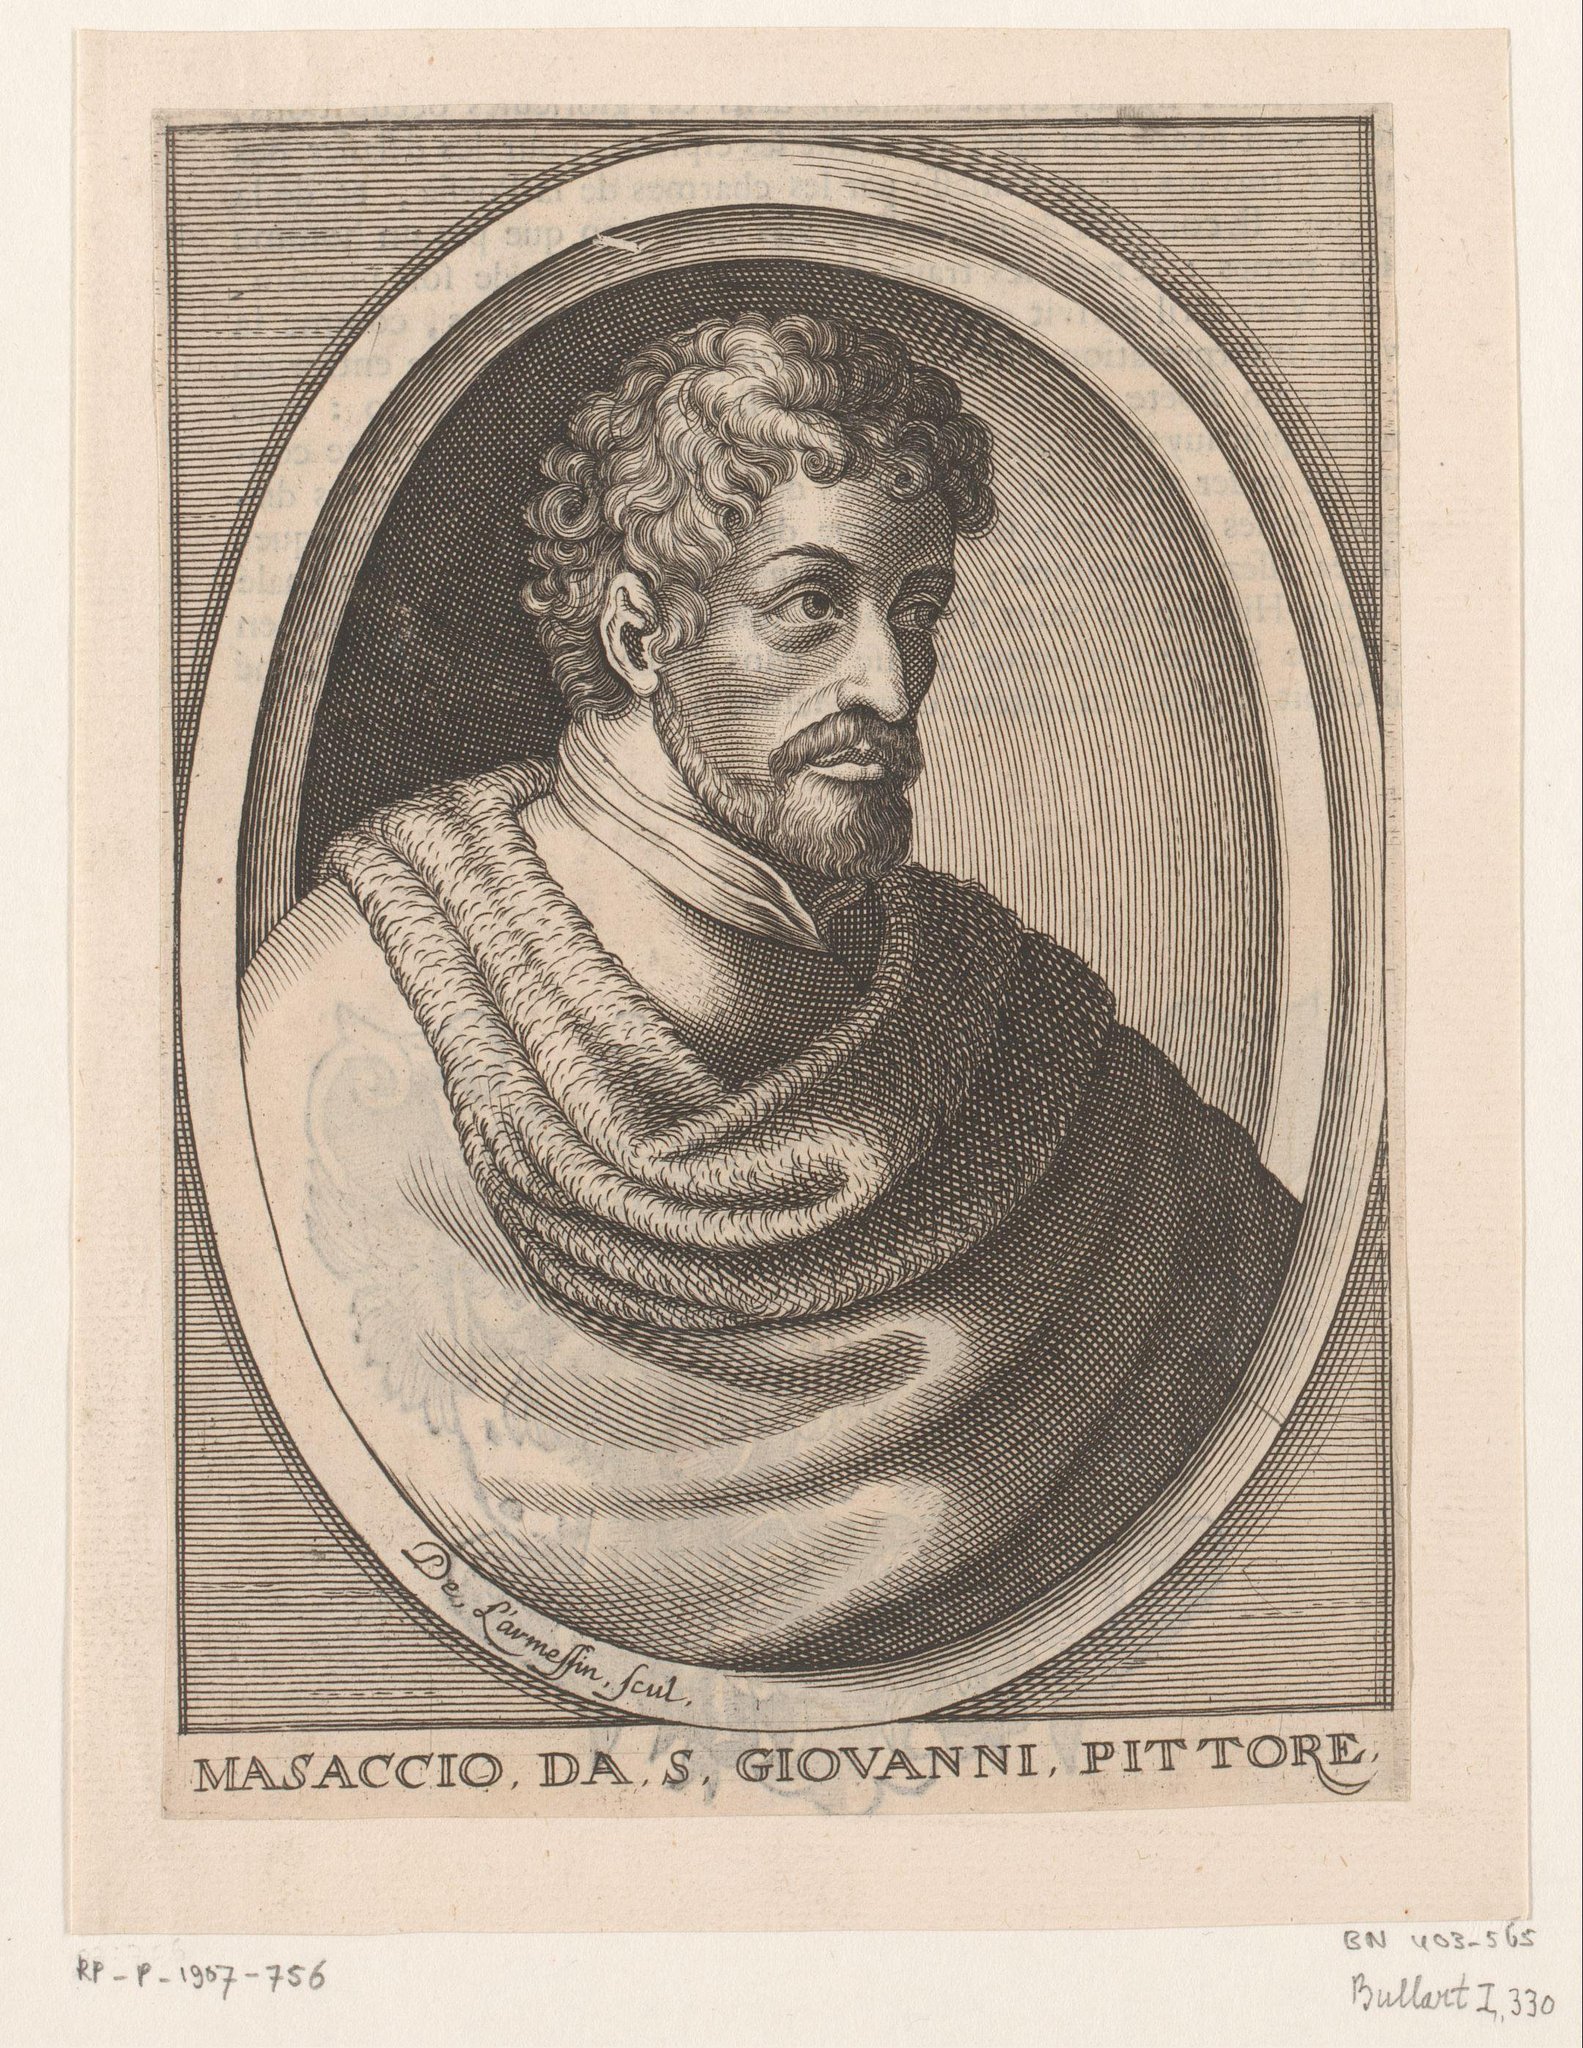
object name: print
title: Portret van Masaccio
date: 1682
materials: paper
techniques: engraving, letterpress printing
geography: brussels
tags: rome, painter, masaccio, historical persons, portrait, self-portrait of artist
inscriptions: collector's mark: Lugt 2228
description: Prent gebruikt voor: Bullart, Isaac. Académie des Sciences et Arts contenant les vies et éloges his. des hommes illustres qui ont excellé en ces professions depuis environ quatre siècles. Brussel: François Foppens, 1682. Het boek werd in 1682 eveneens in Amsterdam uitgegeven door de erfgenamen van Daniel Elzevier. Ieder portret betreft een illustratie bij de biografie van een kunstenaar of geleerde. De meeste portretten werden door Nicolas de Larmessin vervaardigd (162), 93 door De Boulonois en een derde door ongeïdentificeerde prentmakers. Dit betreft een illustratie op p. 330, deel I.